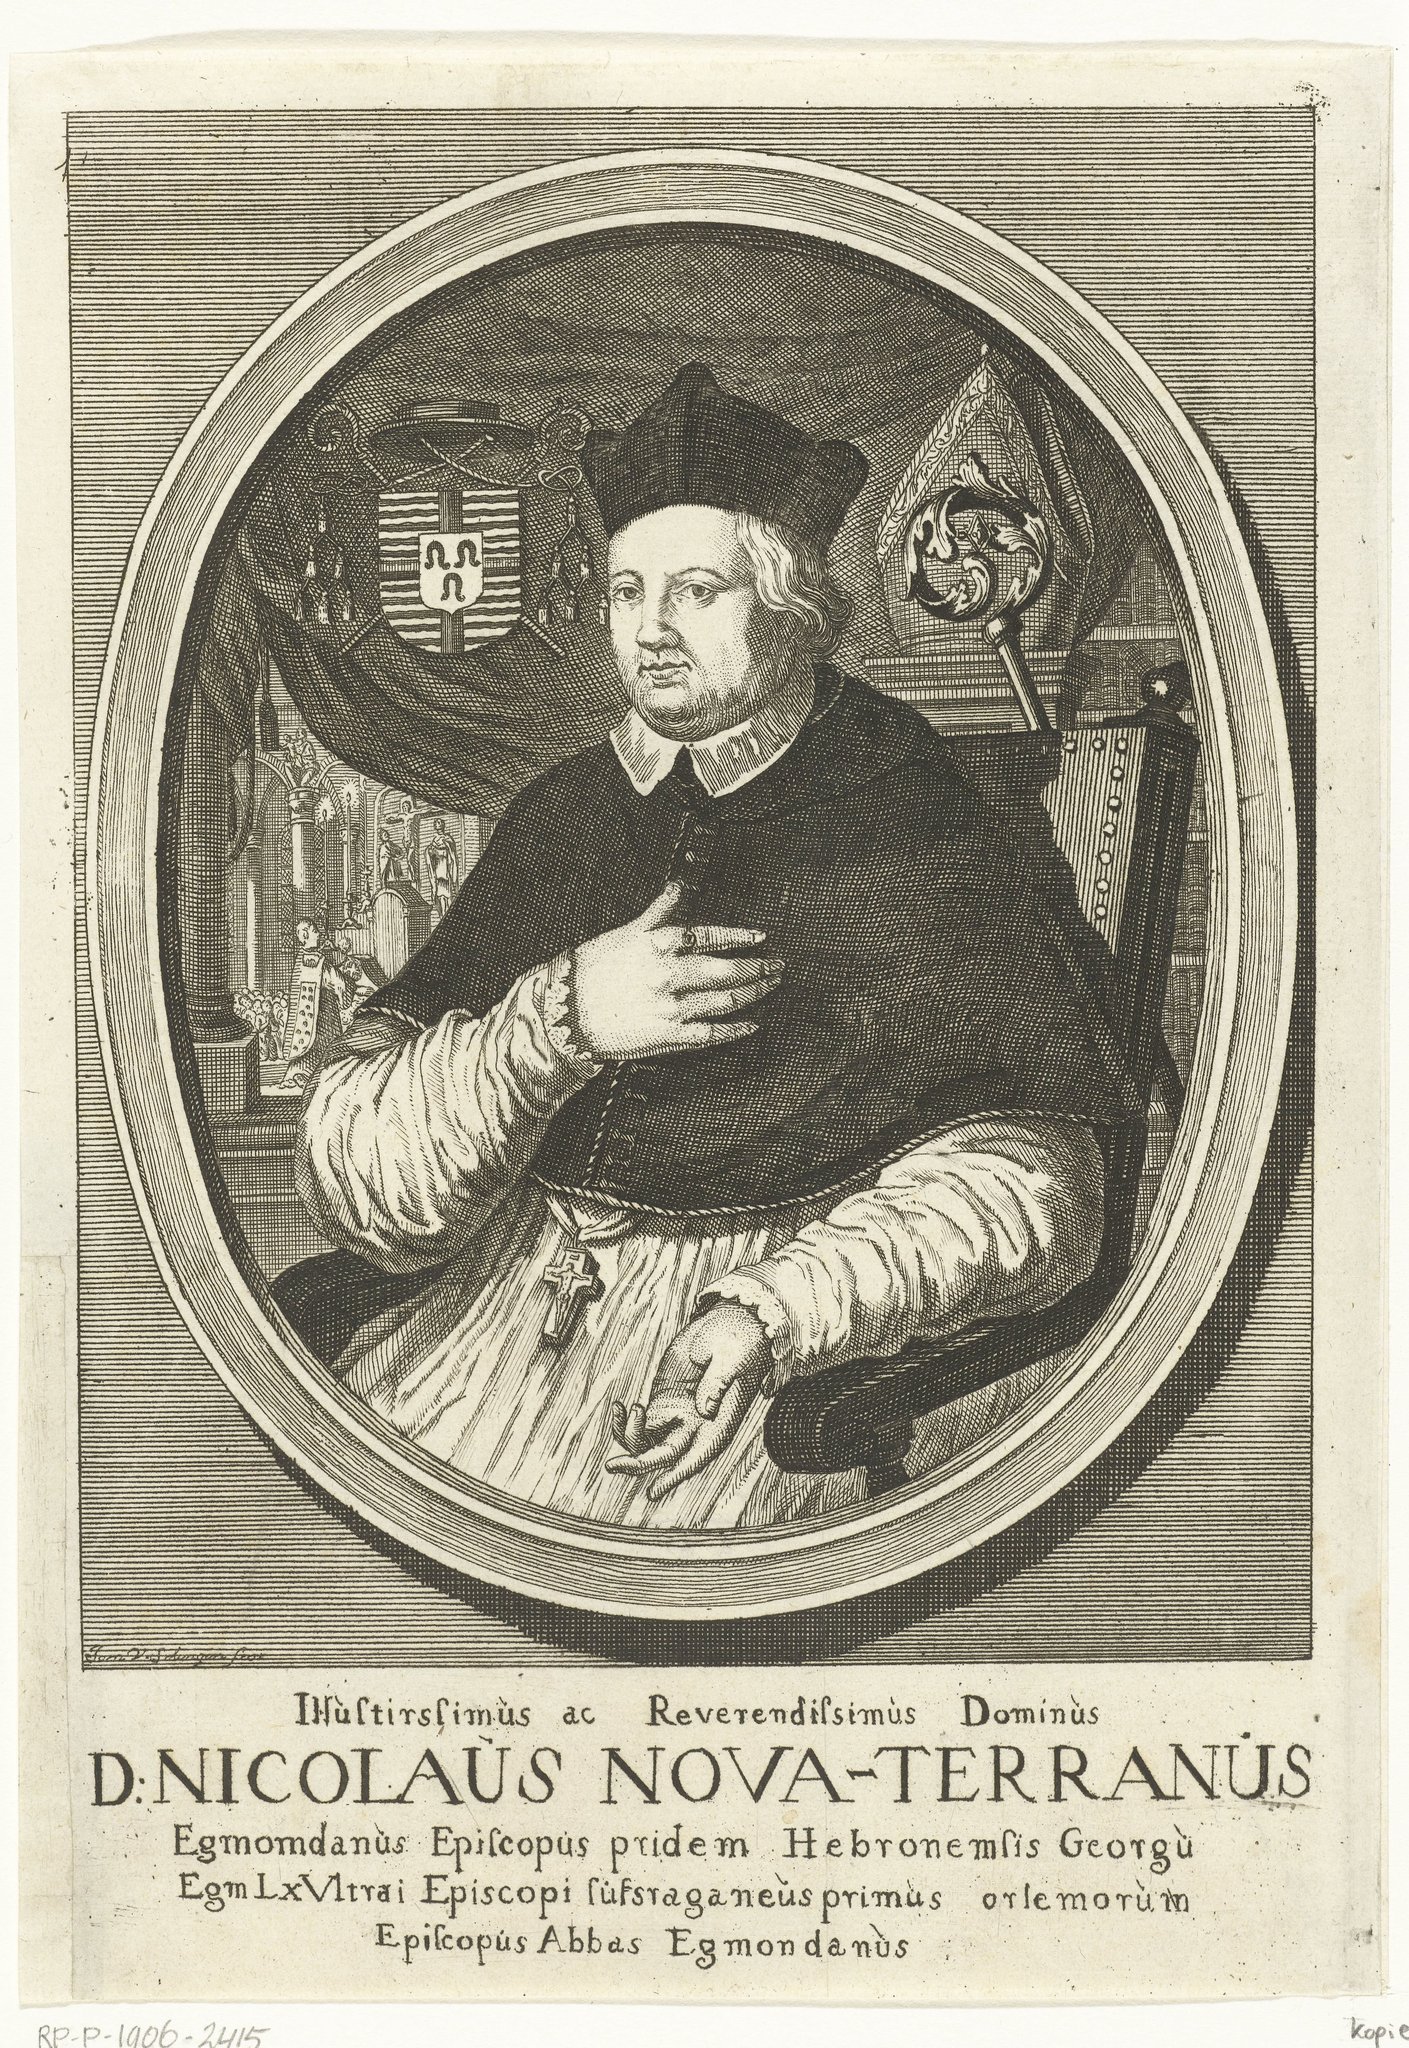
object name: print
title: Portret van bisschop Nicolaas Nieuwland (Nikolaus à Nova Terra) van Haarlem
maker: josua van solingen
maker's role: print maker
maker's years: 1683-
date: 1681-1791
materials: paper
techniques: etching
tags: utrecht, archbishop, bishop, etc. (roman catholic)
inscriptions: collector's mark: Lugt 2228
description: Portret van bisschop Nicolaas Nieuwland (Nikolaus à Nova Terra) zittend op stoel met attributen behorend bij zijn functie, achter de stoel zijn kromstaf en mijter zichtbaar en het wapen van de man.